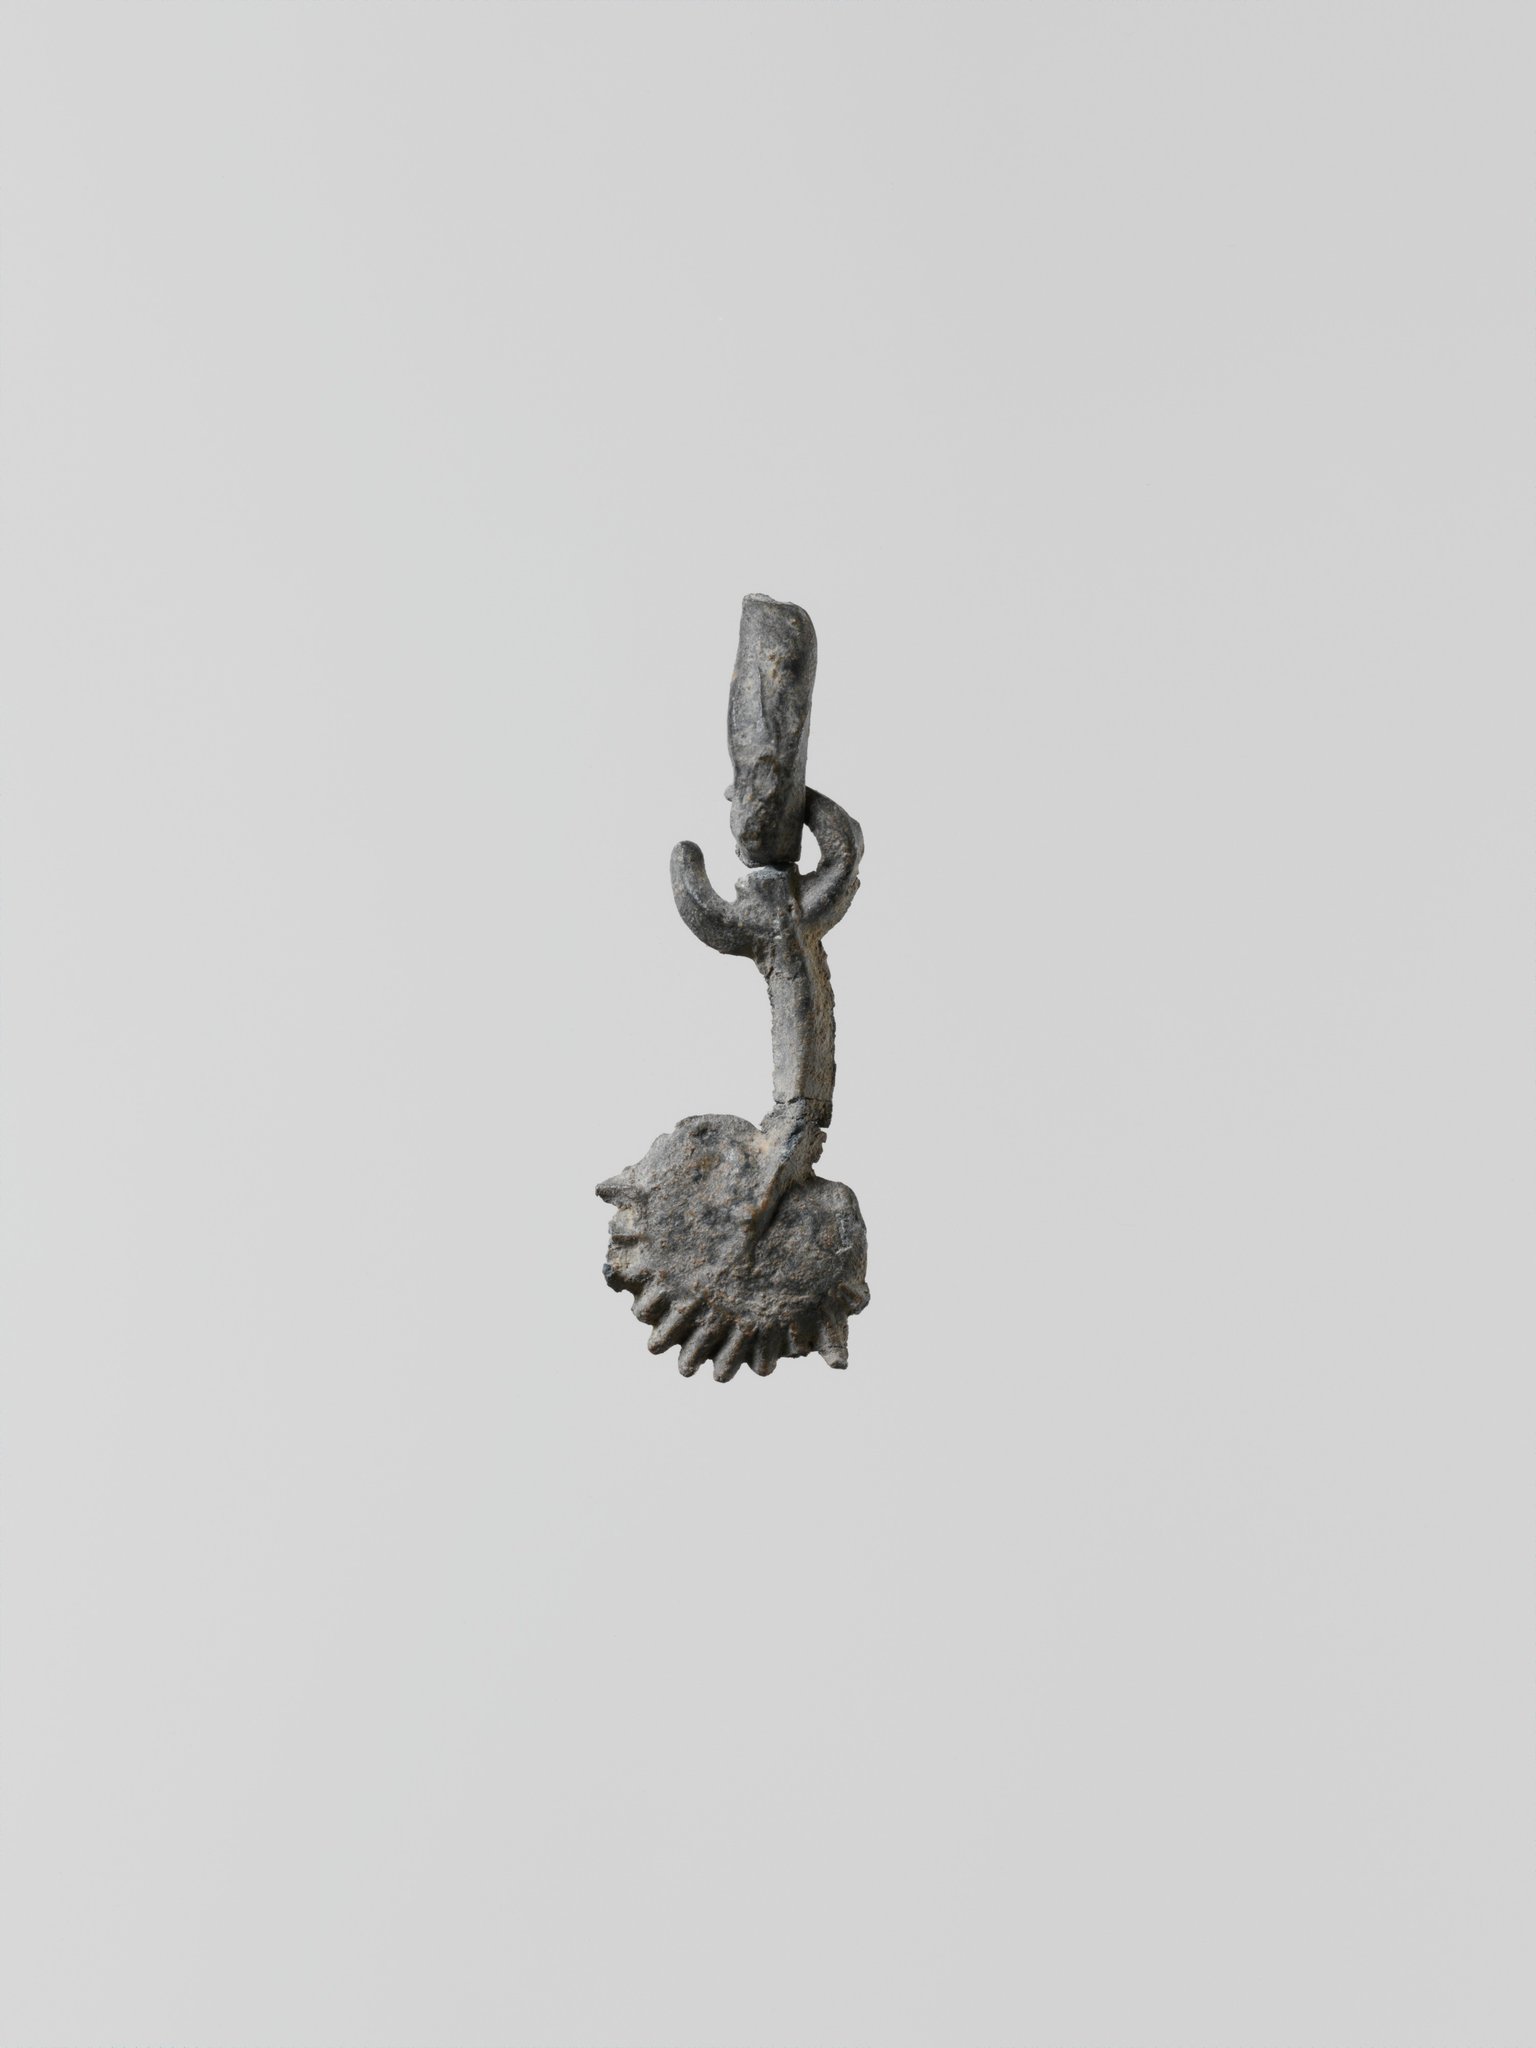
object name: ornament, 14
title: Lead ornament, perhaps vegetal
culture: greek, laconian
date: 600-401 BCE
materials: lead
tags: human figures